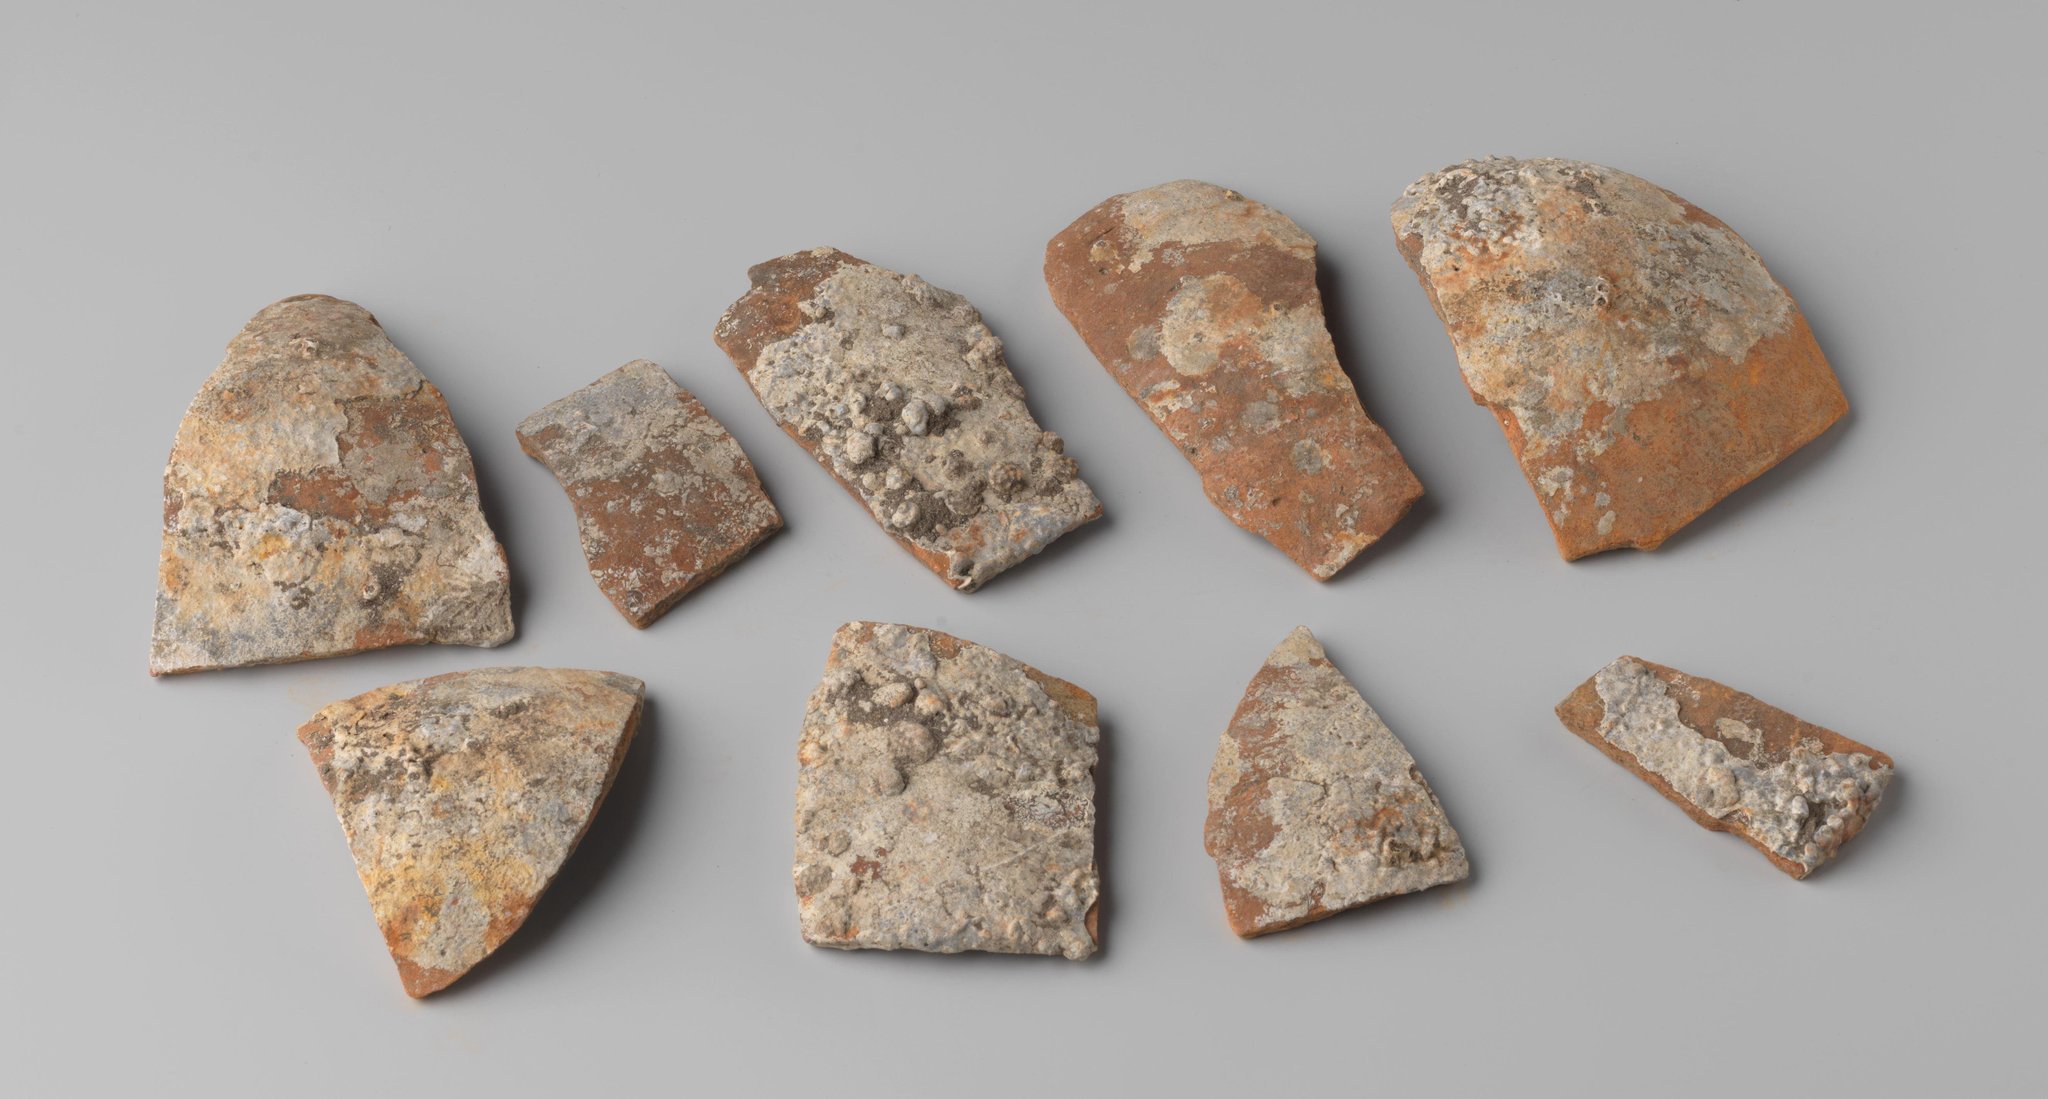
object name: sherd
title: Scherven aardewerk uit V.O.C.-schip de 'Witte Leeuw'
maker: Anonymous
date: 1613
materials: earthenware, glaze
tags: verenigde oostindische compagnie, sint-helena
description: Scherven geglazuurd roodbakkend aardewerk uit V.O.C.-schip de 'Witte Leeuw'.